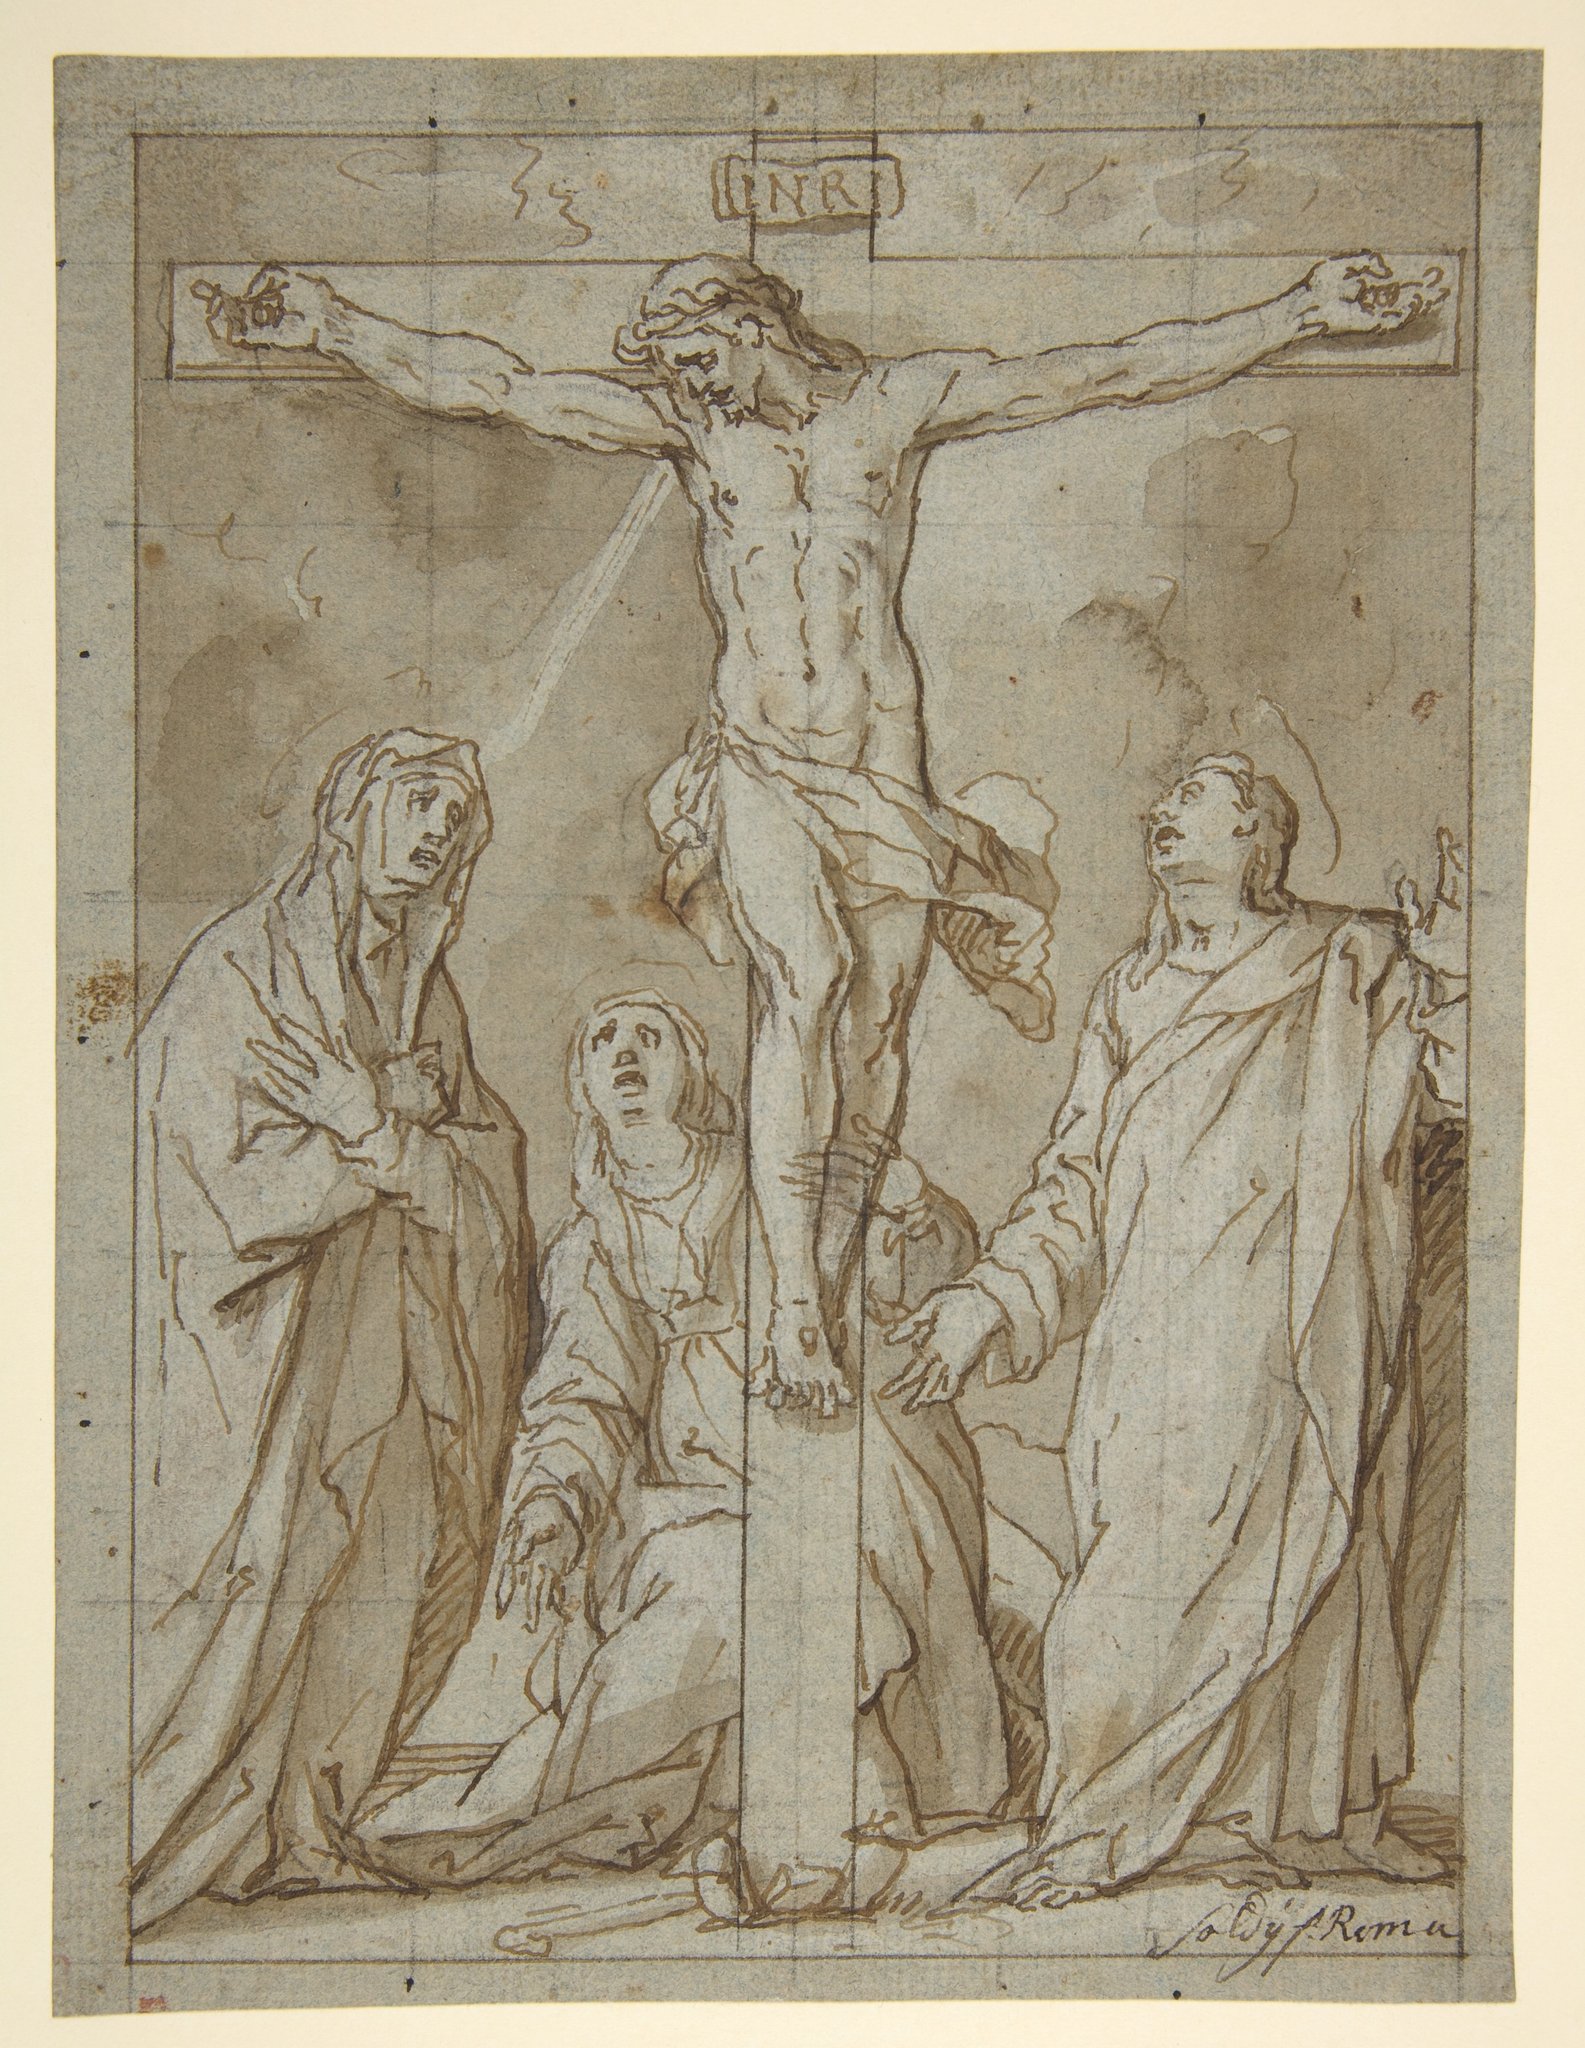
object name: drawing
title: Christ Crucified, Attended by the Virgin, Saint Mary Magdalen, and Saint John the Evangelist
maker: lazzaro tavarone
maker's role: artist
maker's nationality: italian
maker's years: 1556-1641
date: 1556-1641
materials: chalk, ink, paper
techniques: pen, drawing, wash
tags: christ,mary magdalene,saint john the evangelist,virgin mary,crucifixion